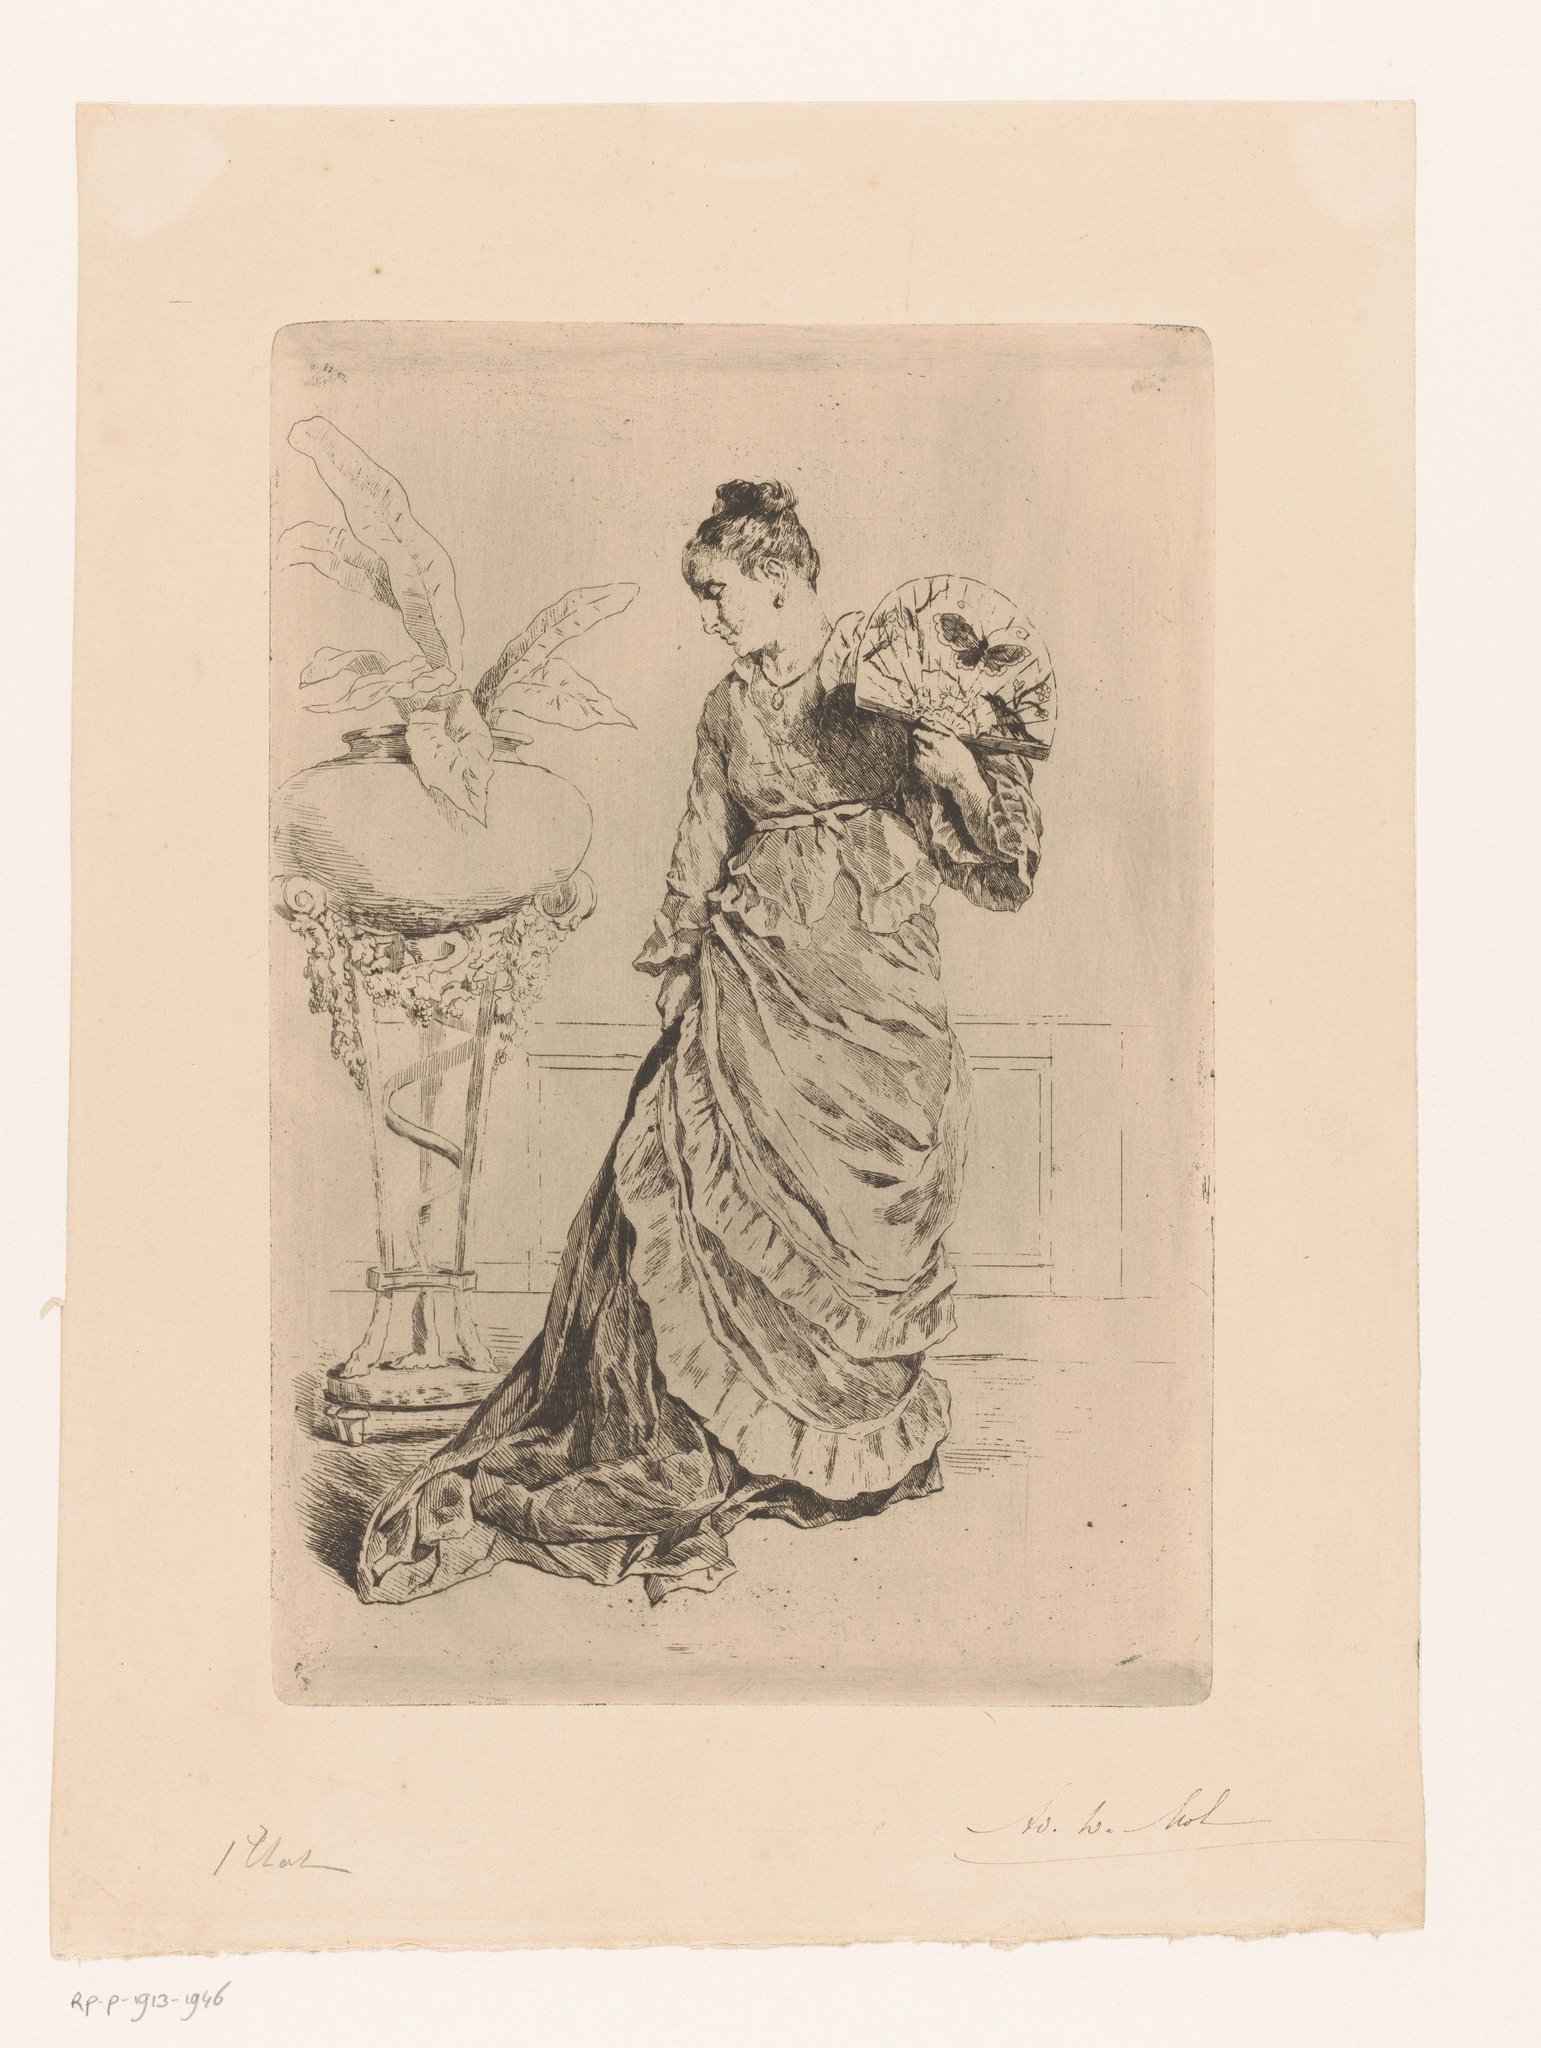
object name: print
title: Vrouw met waaier staand naast een vaas op sokkel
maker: adolphe léonard de mol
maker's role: print maker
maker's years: 1834-1877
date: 1844-1877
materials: paper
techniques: drypoint, etching, intaglio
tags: adult woman, vase ~ ornament, fan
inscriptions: collector's mark: Lugt 2228